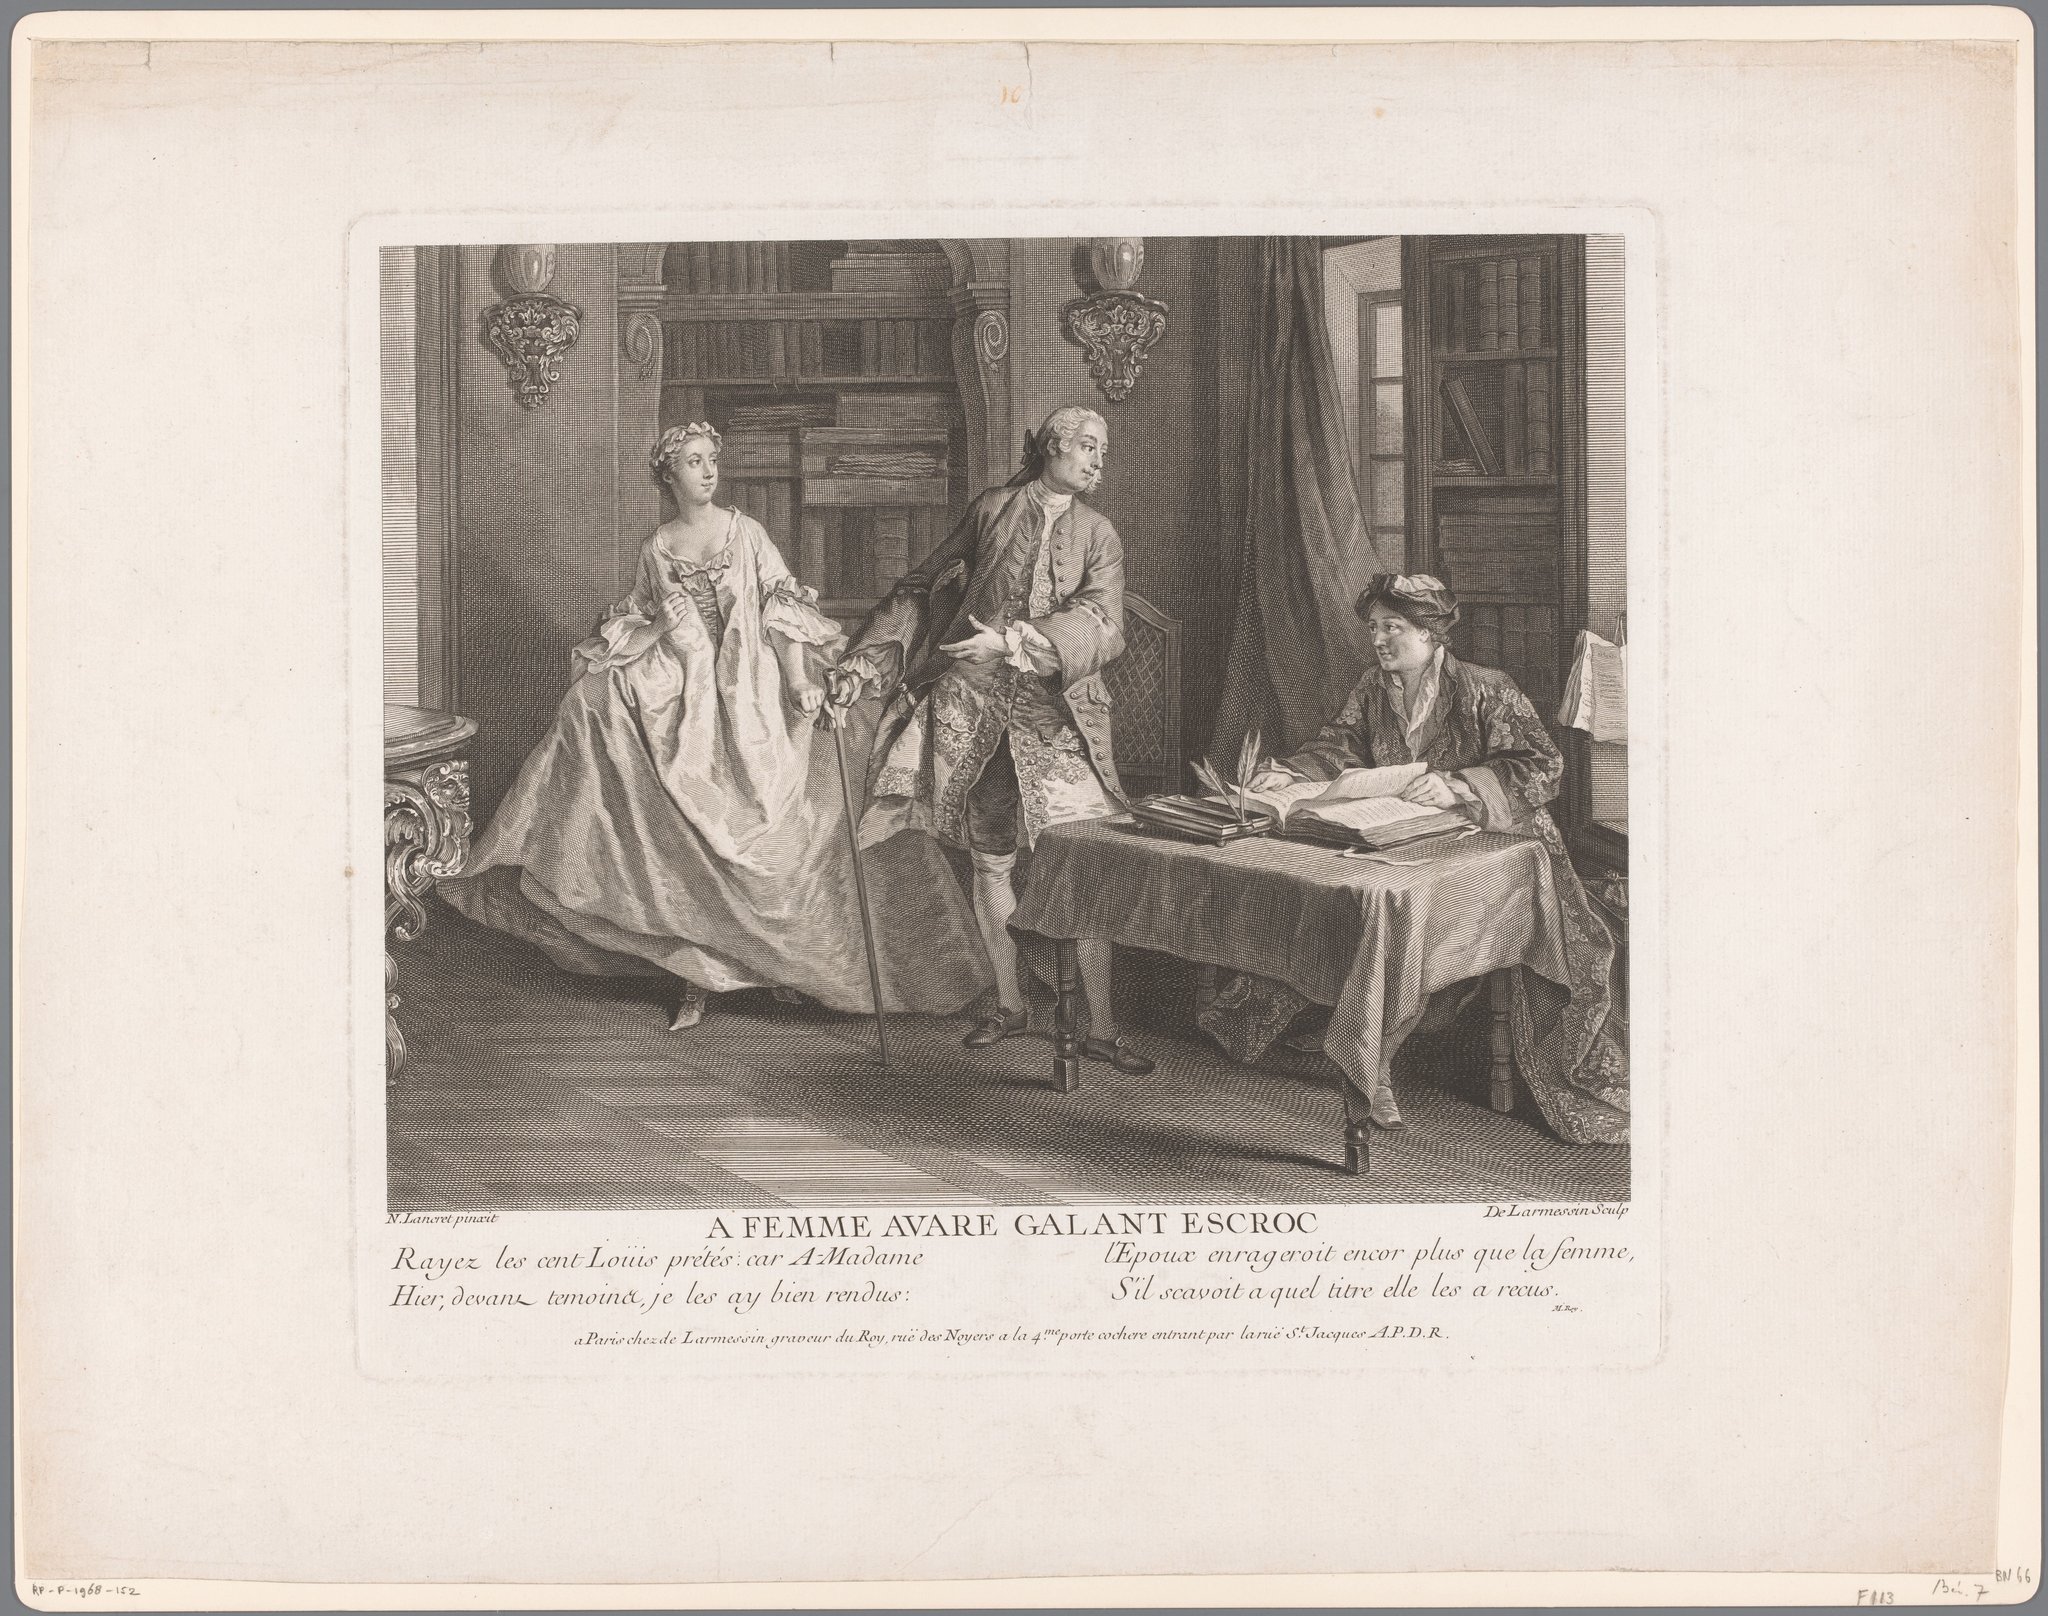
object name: print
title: A femme avare, galant escroc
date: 1740-1755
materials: paper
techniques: engraving, etching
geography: paris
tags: clothing for the upper part of the body (vest) (+ men's clothes), dress, gown: robe volante (+ women's clothes), head-gear (montero) (+ men's clothes), housecoat (+ men's clothes), coat (justaucorps) (+ men's clothes), clothes, costume (+ women's clothes), clothes, costume (+ men's clothes), trousers, breeches, etc. (breeches) (+ men's clothes), walking-stick, staff, cane (+ men's clothes)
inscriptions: collector's mark: Lugt 2228, collector's mark: Lugt 2760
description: Maakt deel uit van een 38-delige serie met prenten bij de verhalen van La Fontaine, gegraveerd tussen 1736-1743.